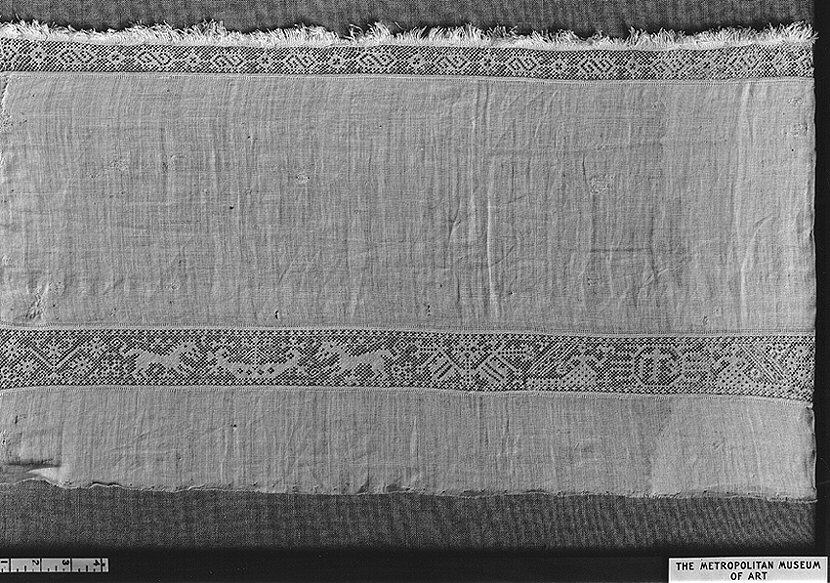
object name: cover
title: End of a cover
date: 1601-1700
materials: linen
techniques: embroidery